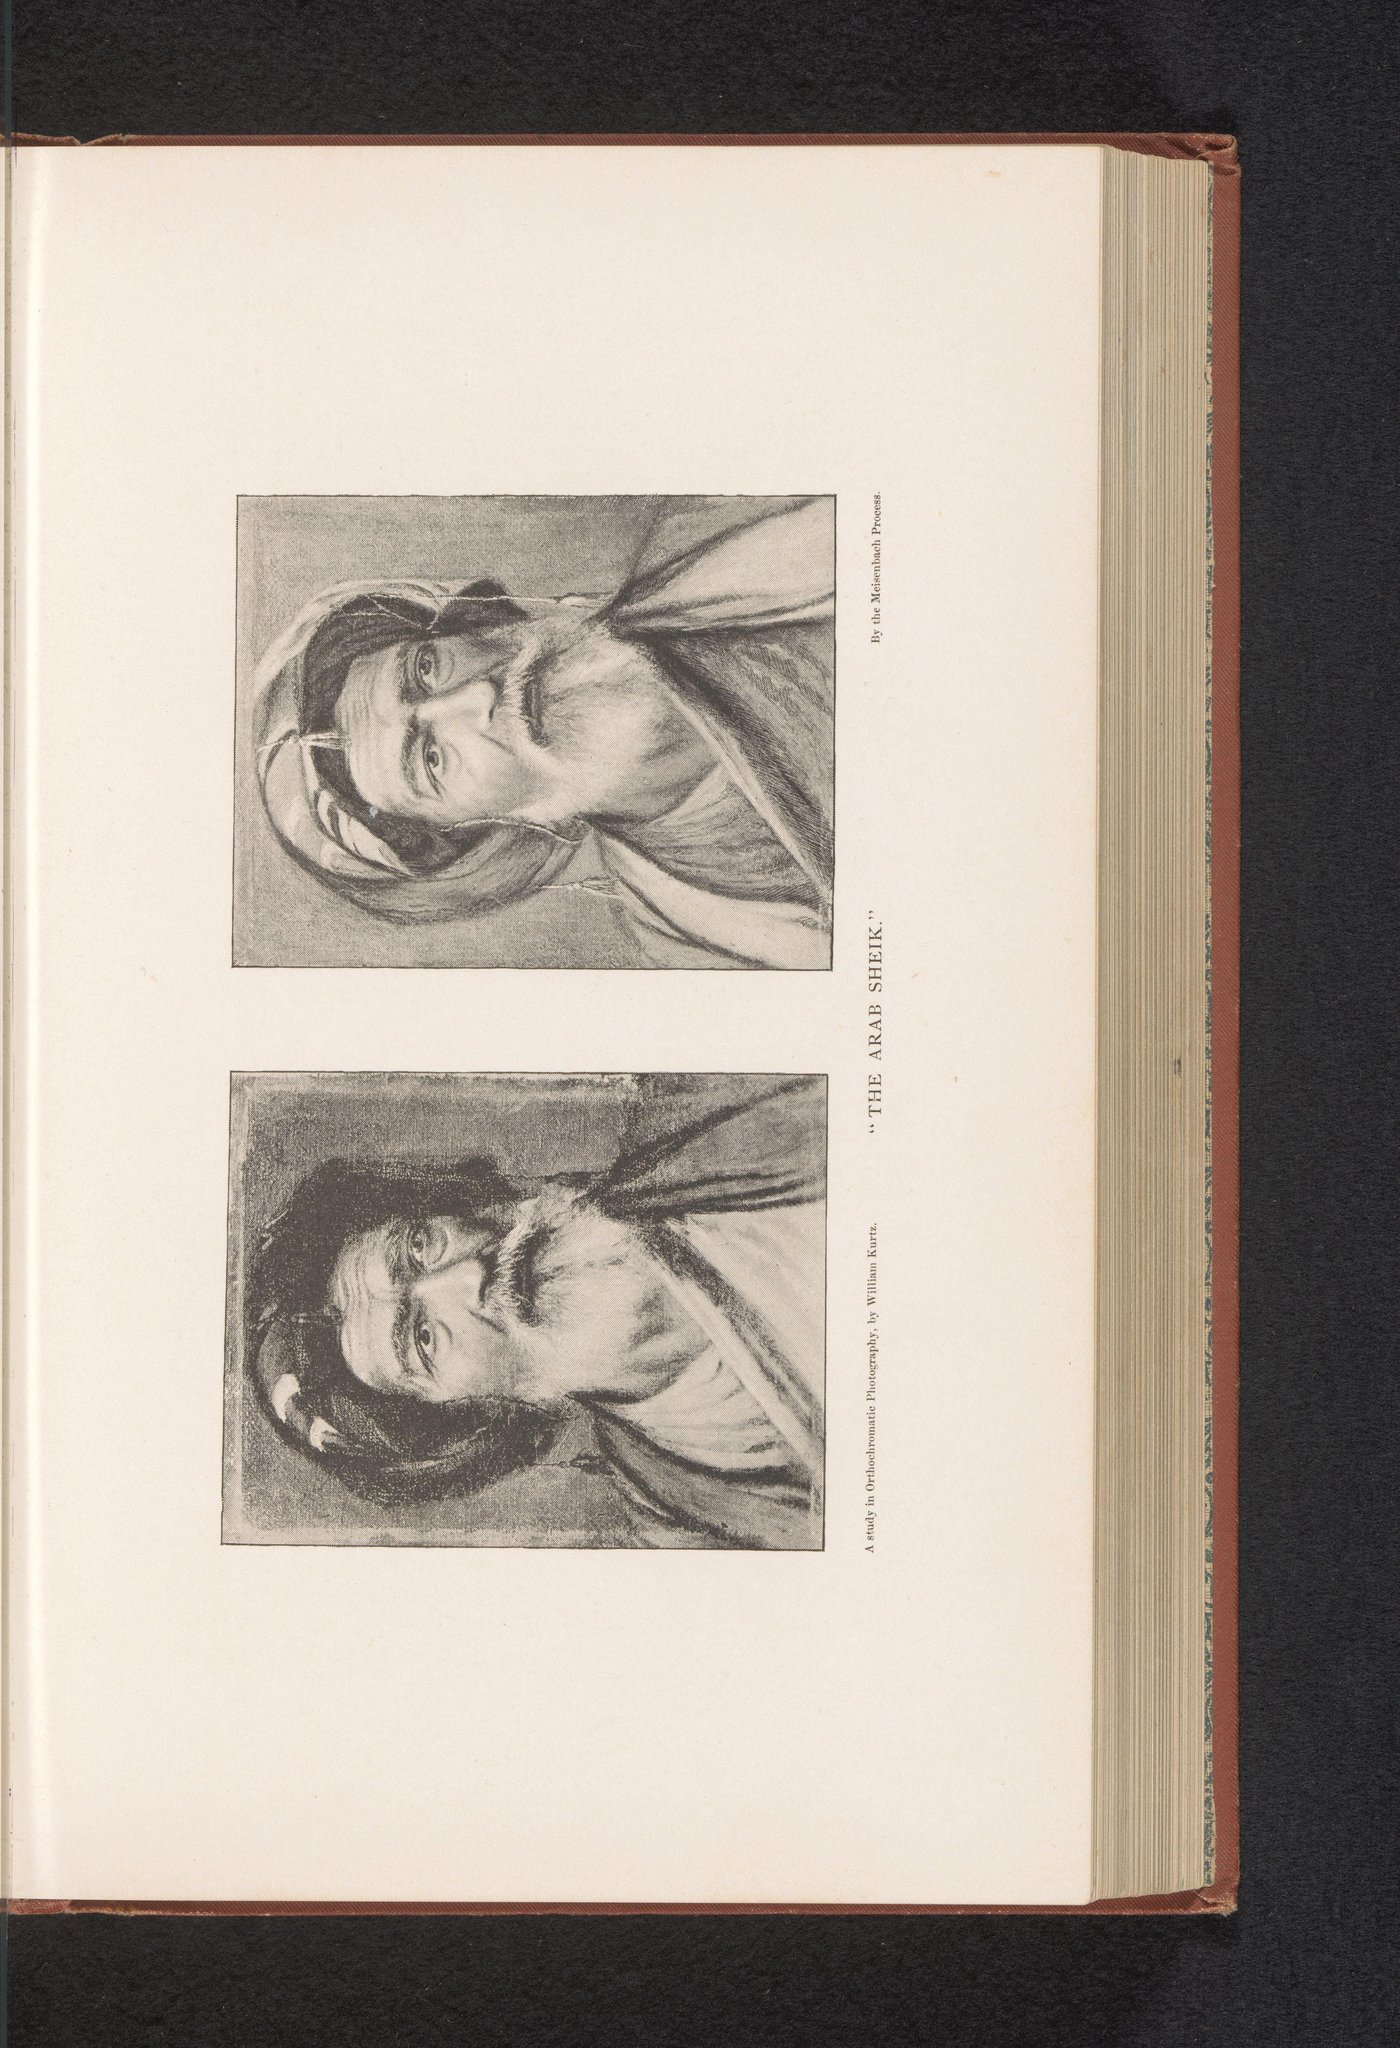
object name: page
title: Twee voorbeelden van orthochromatische fotografie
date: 1884-1889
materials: paper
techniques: autotype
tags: adult man, head-gear: turban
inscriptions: inscription: ‘A study in Orthochromatic Photography, by William Kurtz.’, inscription: ‘By the Meisenbach Process’